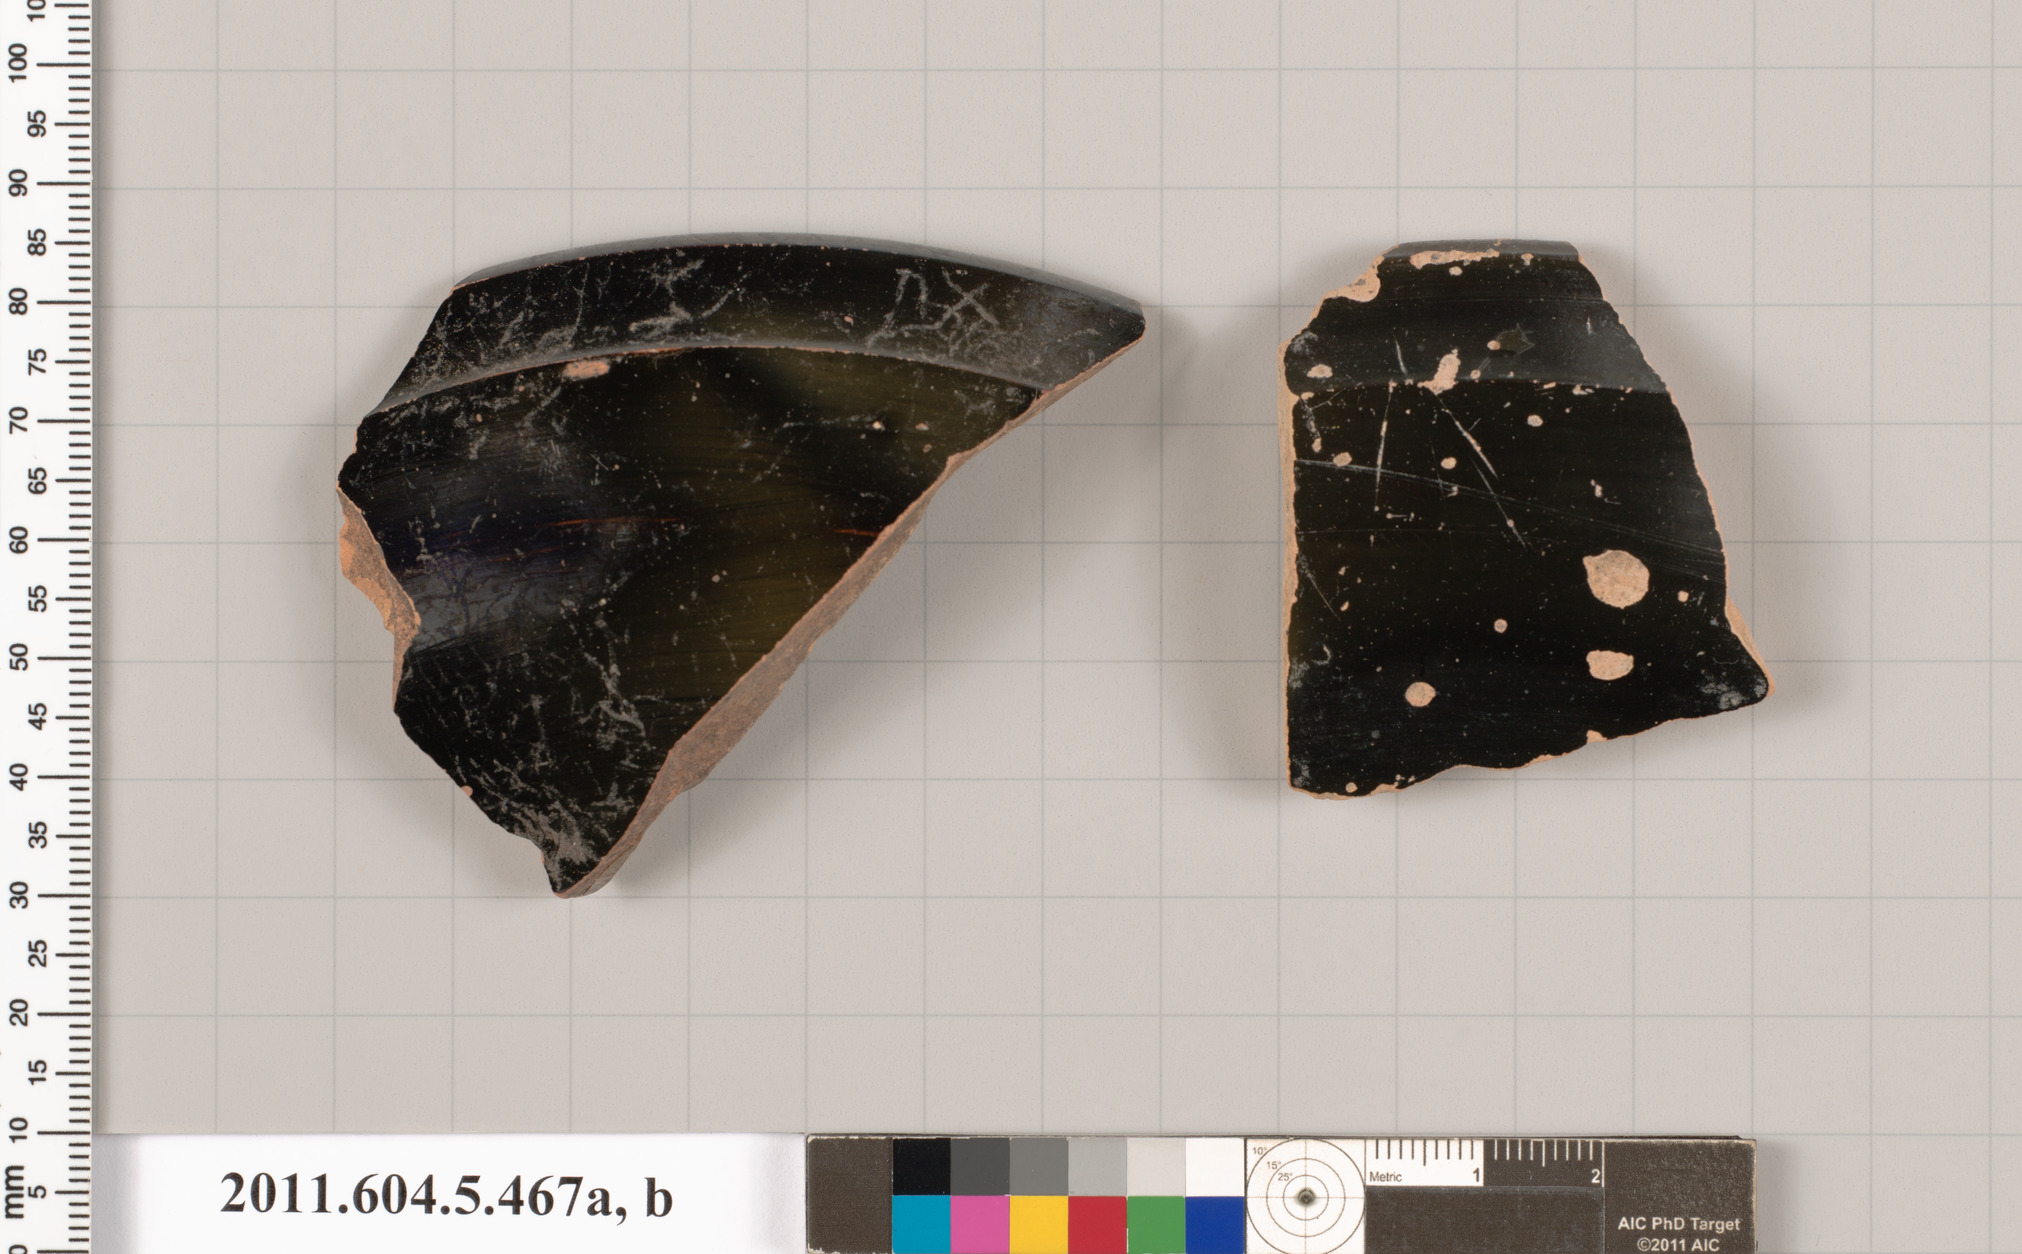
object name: kylix fragment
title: Terracotta rim fragments of stemless kylikes (drinking cups)?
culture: greek, attic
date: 600-401 BCE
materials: terracotta